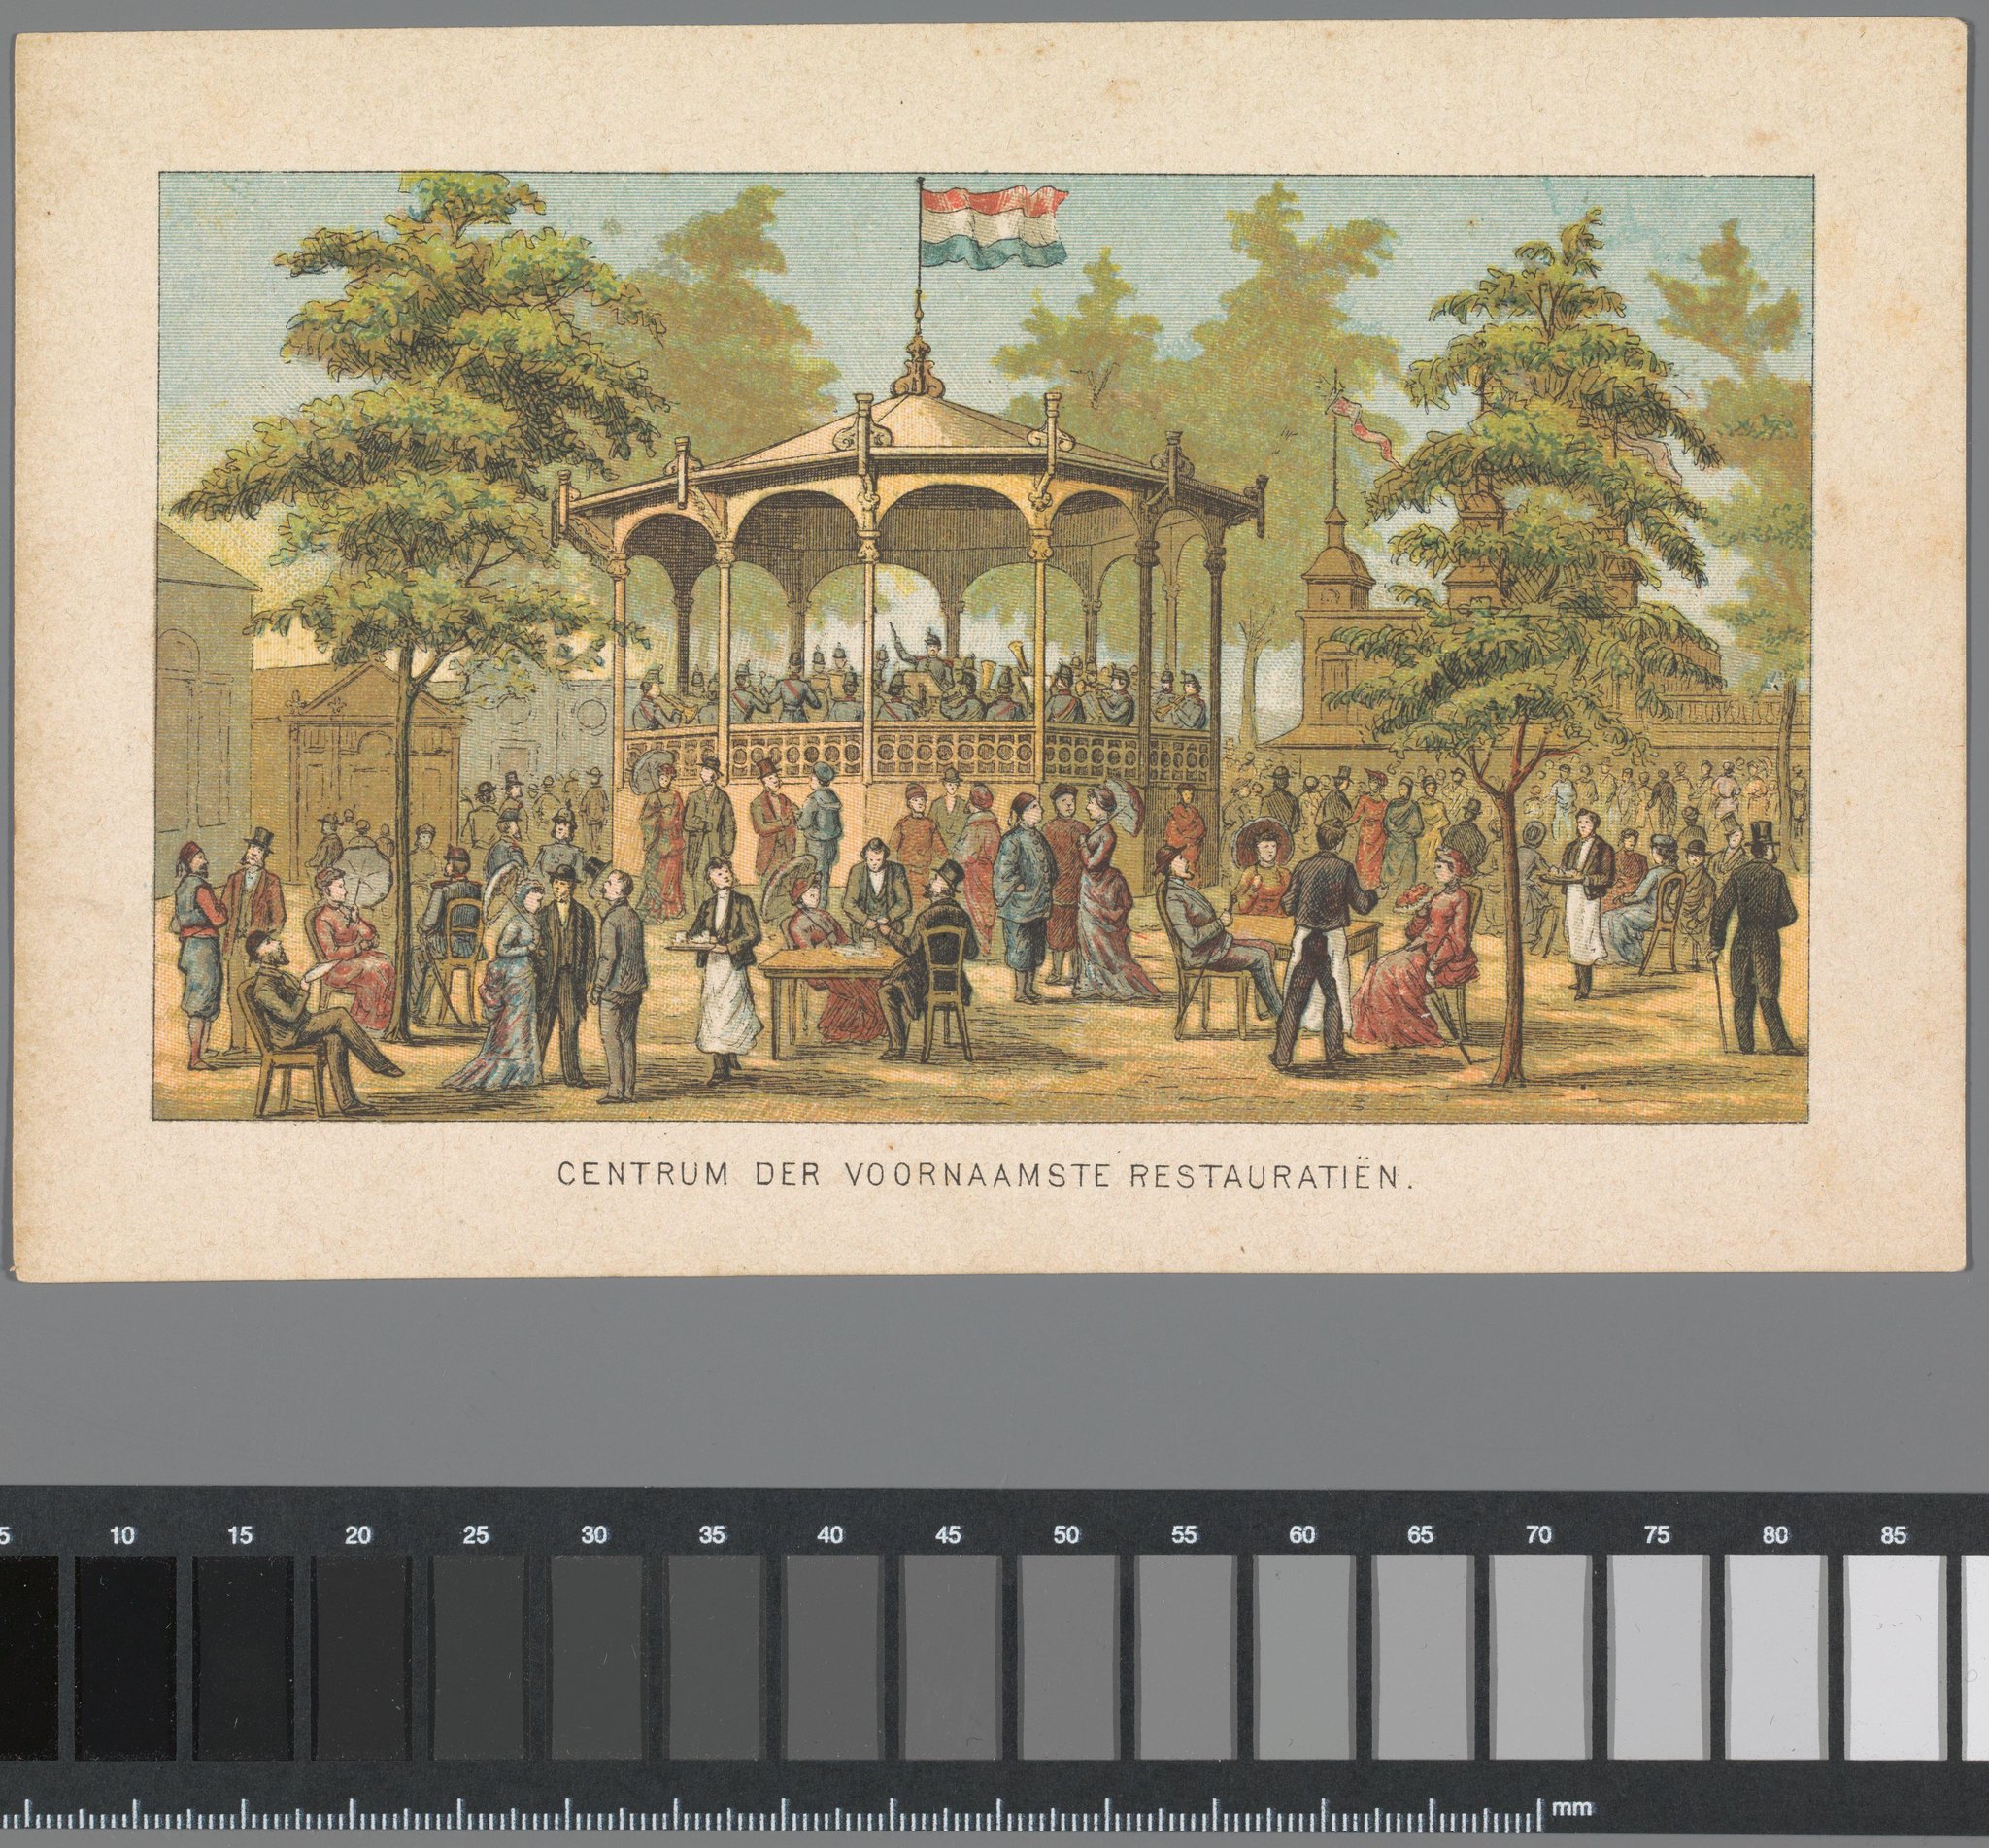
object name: print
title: Centrum der voornaamste restauratiën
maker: Anonymous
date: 1883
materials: paper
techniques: chromolithography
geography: netherlands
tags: world fair, world exhibition, amsterdam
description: Gezicht op de restauratie en muziektent op de Wereldtentoonstelling op het Museumplein te Amsterdam. Onderdeel van een groep van zestien platen en een plattegrond van de Wereldtentoonstelling in Amsterdam van 1 mei tot 1 oktober 1883. Uitgave van het Nieuws van den Dag.